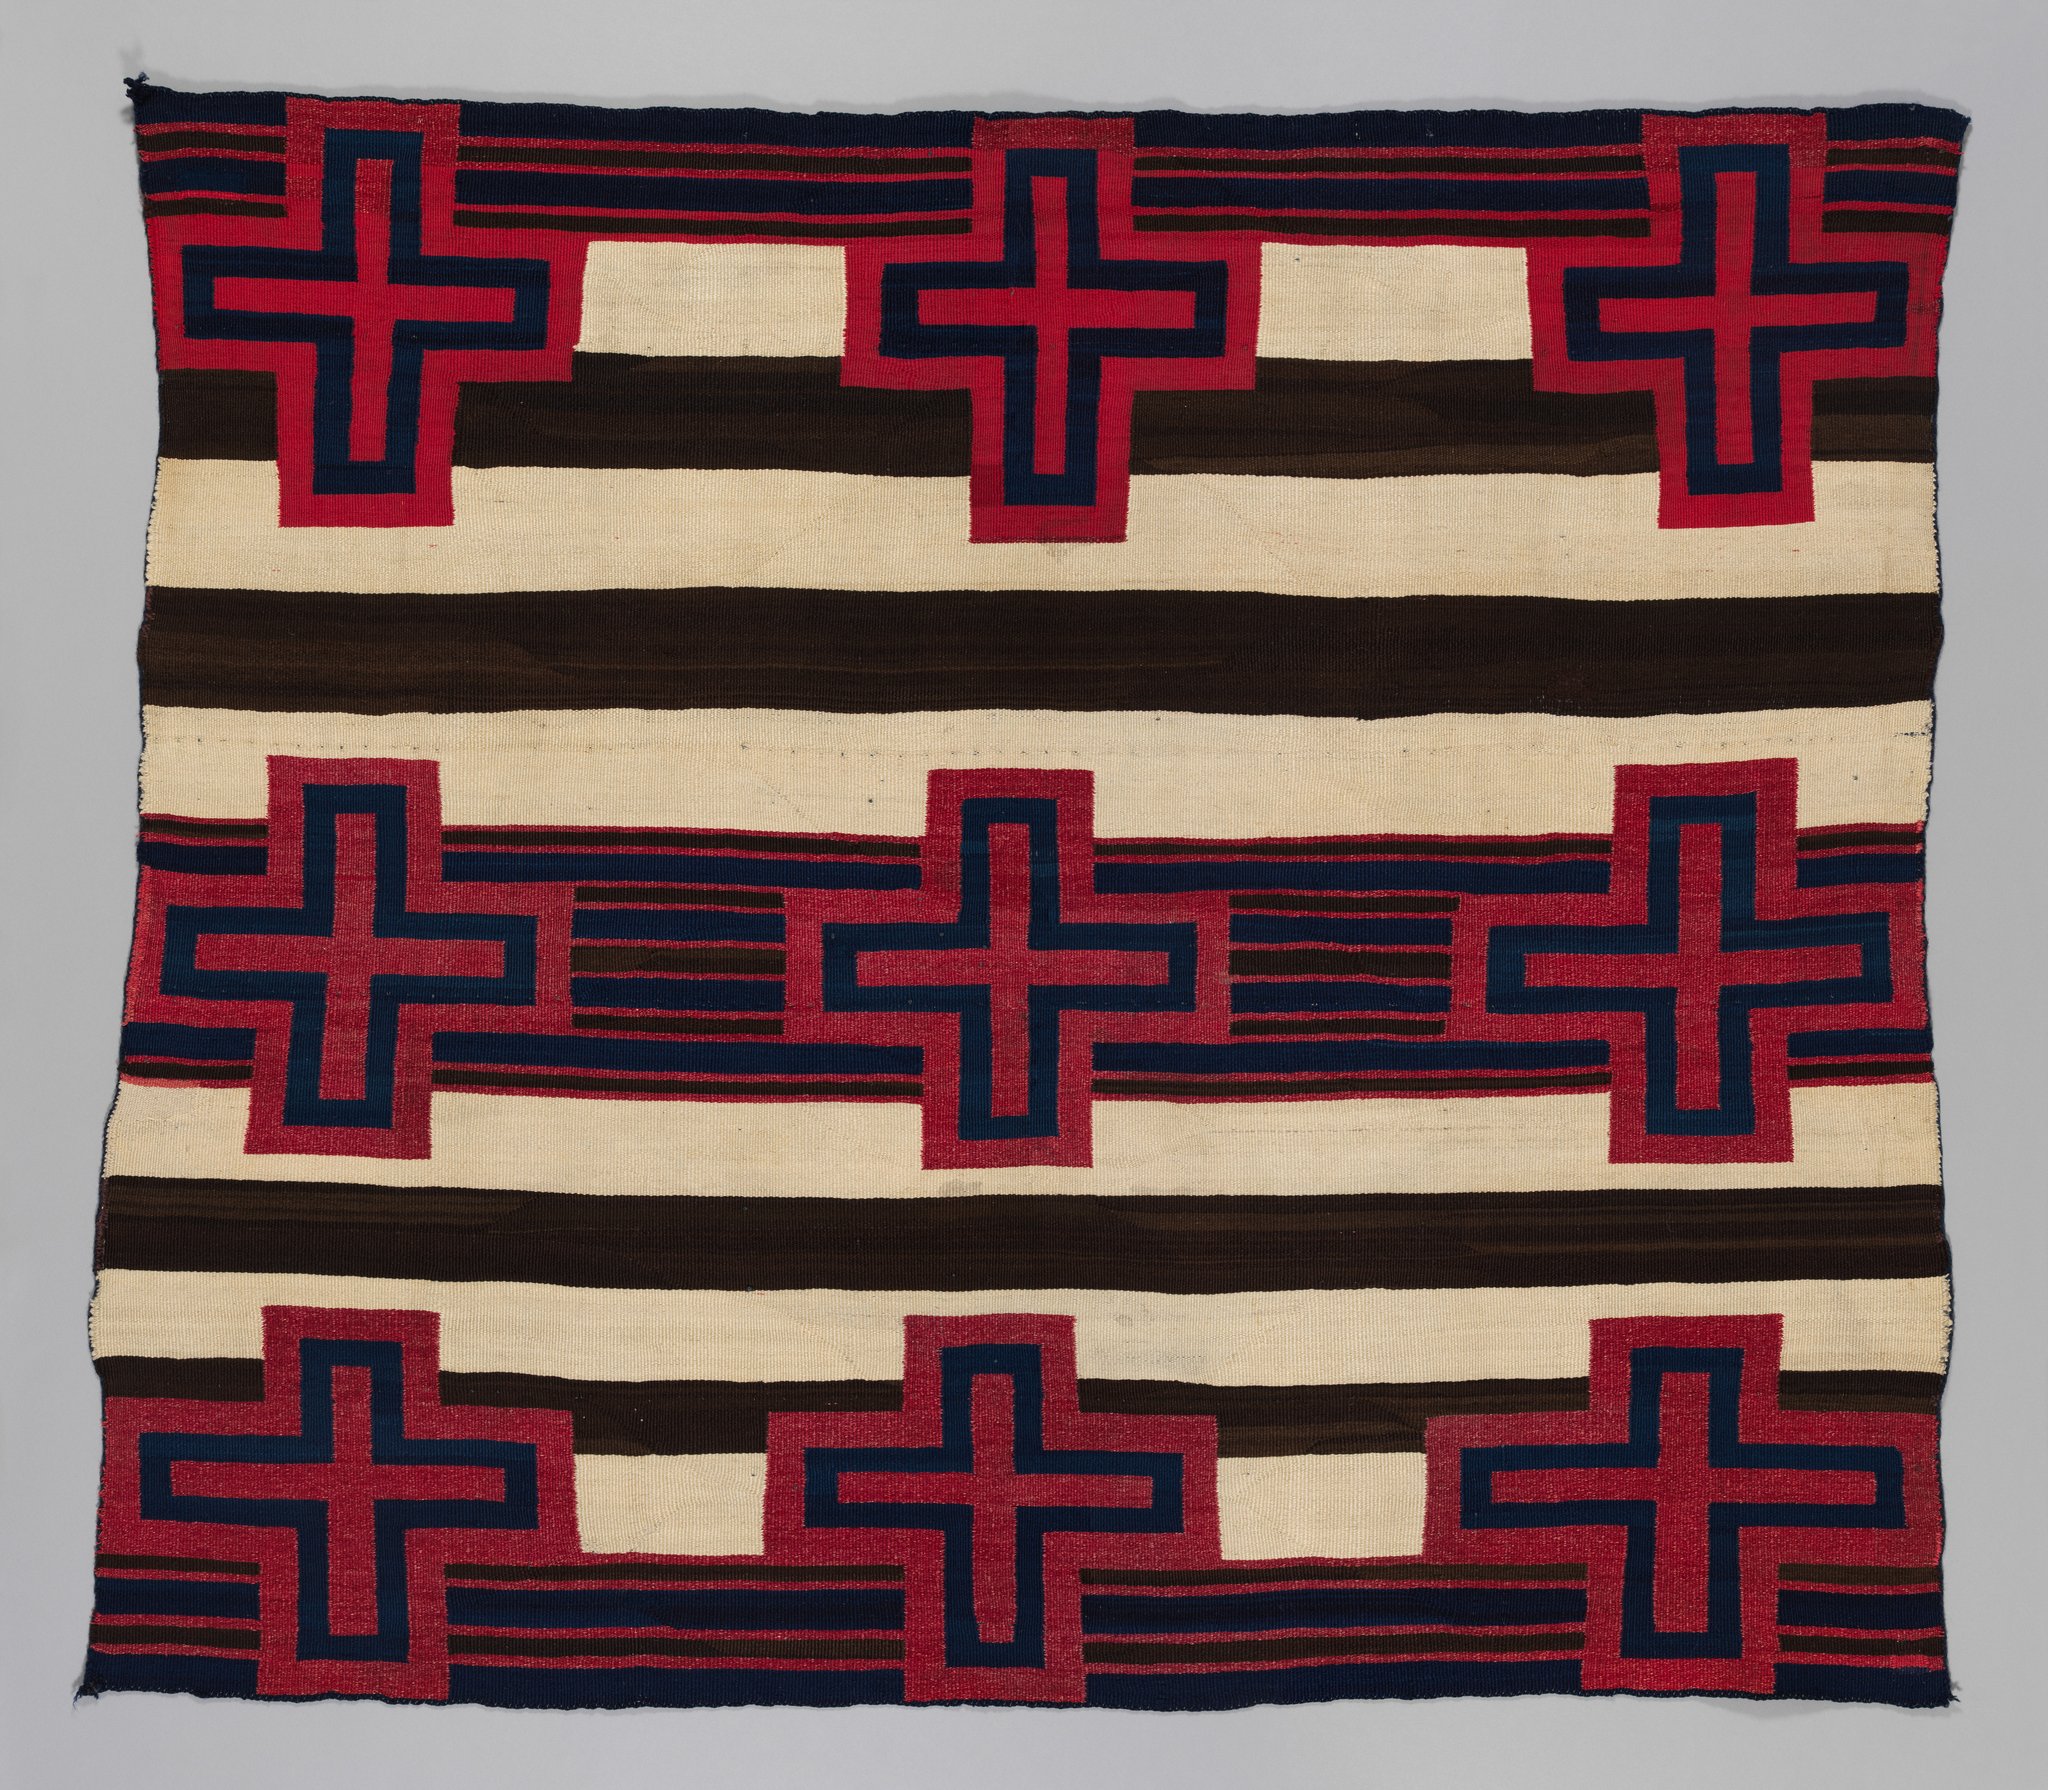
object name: blanket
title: Chief's blanket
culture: diné or navajo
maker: unidentified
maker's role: artist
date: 1865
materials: wool